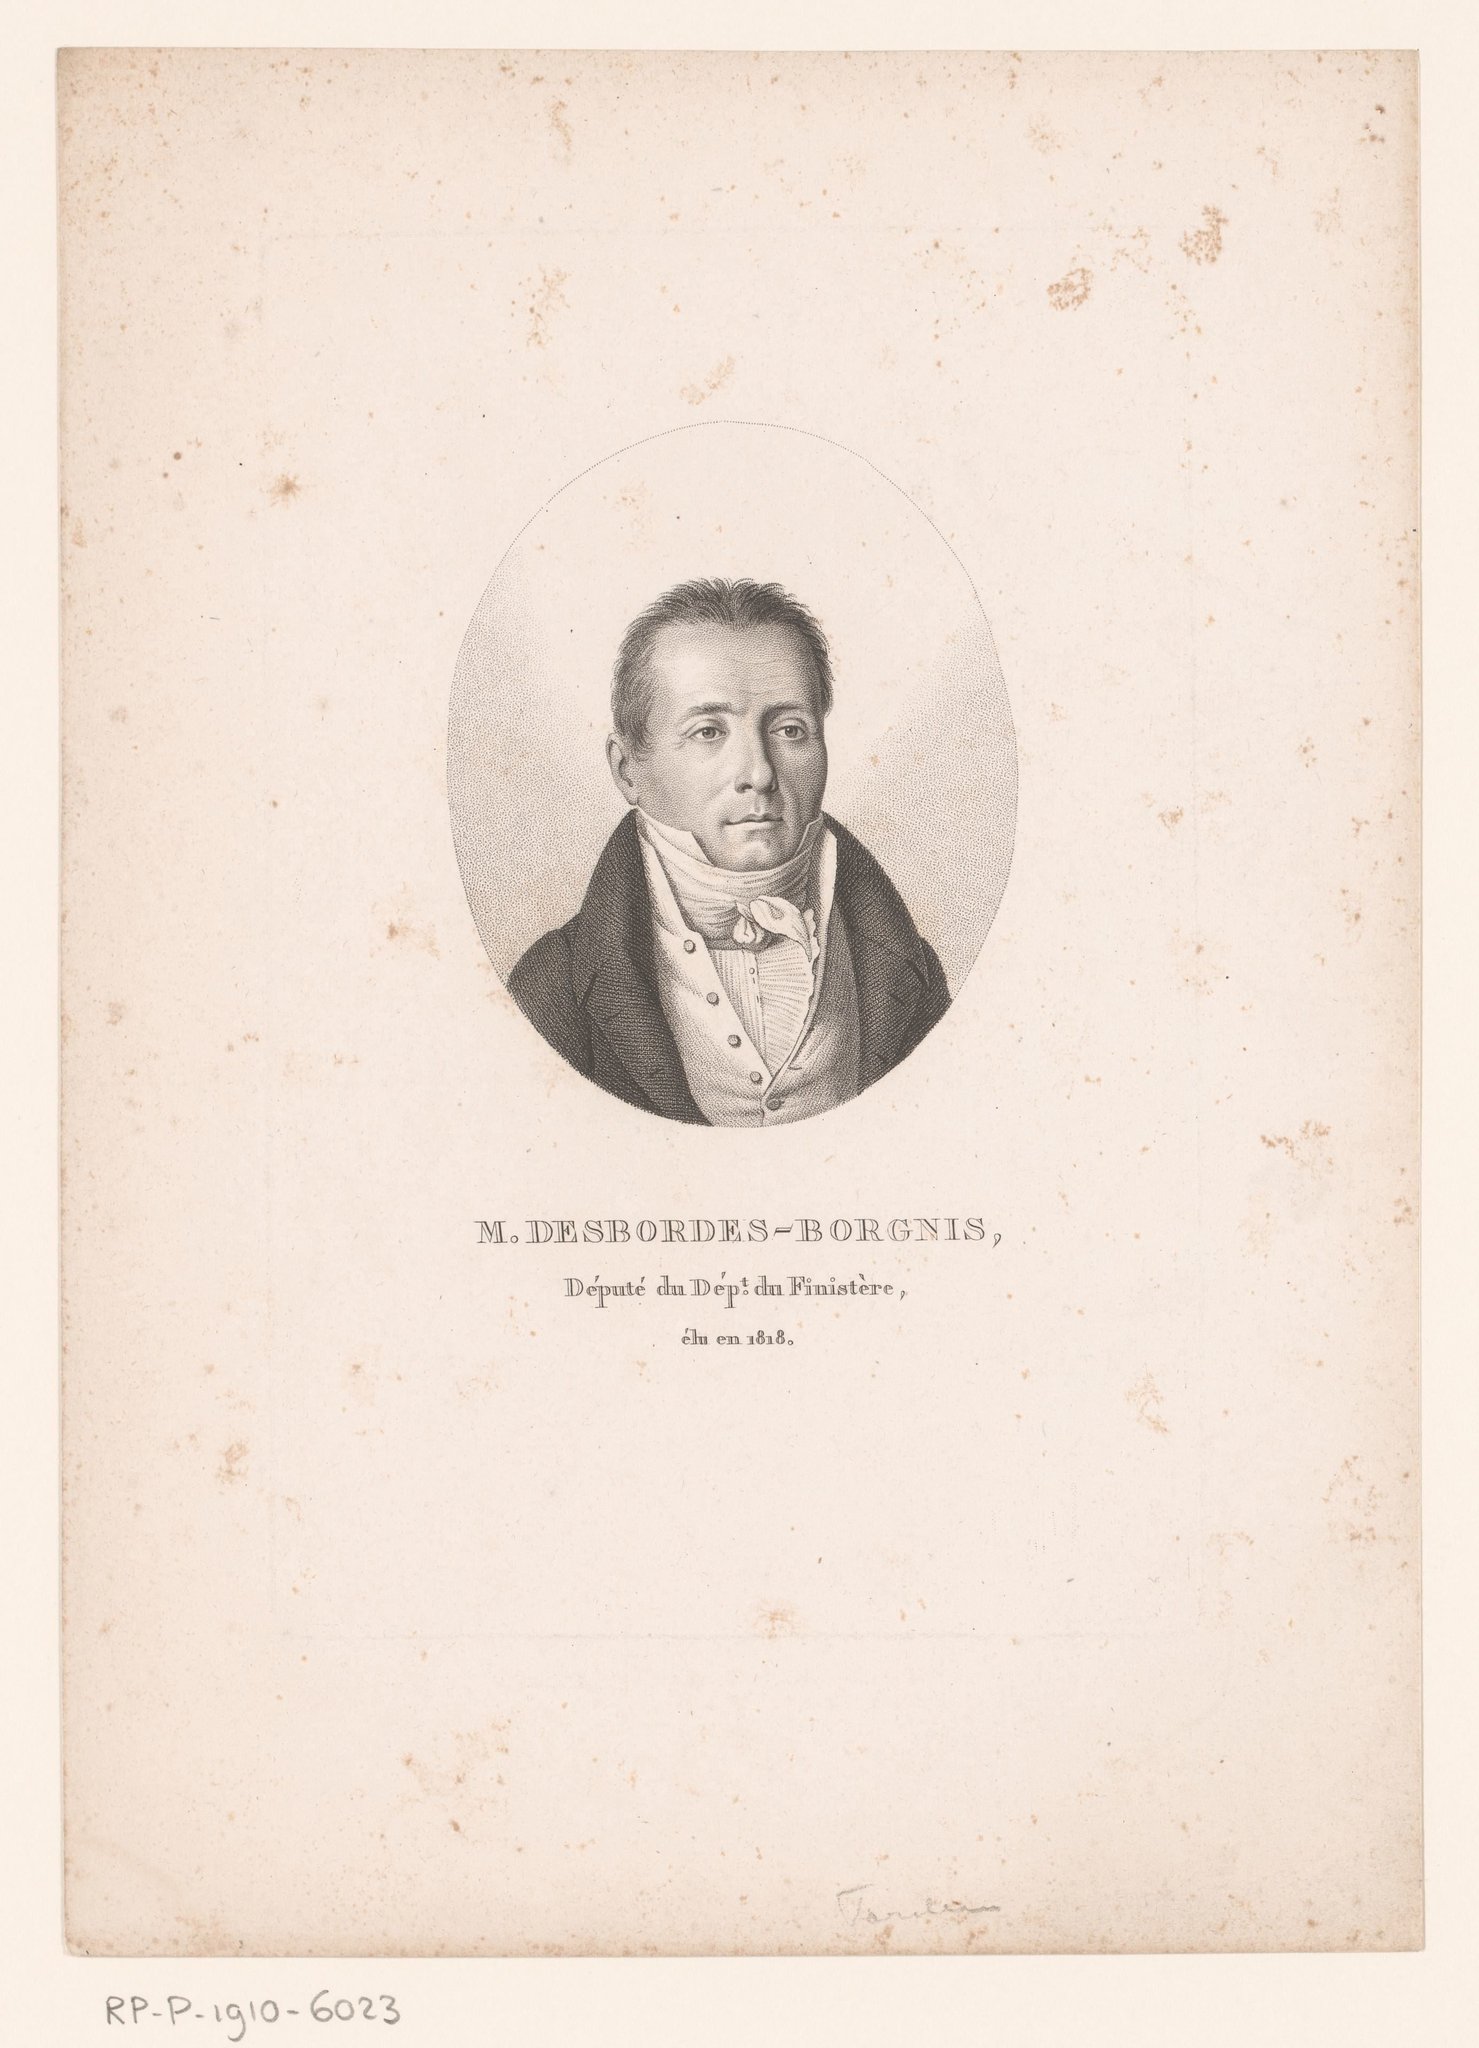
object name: print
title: Portret van François-Marie Borgnis-Desbordes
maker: ambroise tardieu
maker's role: print maker, printer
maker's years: 1788-1841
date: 1820-1821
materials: paper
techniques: engraving, roulette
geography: paris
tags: politician, historical persons, politician, e.g. party leader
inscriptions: collector's mark: Lugt 2228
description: Prent uit: Tardieu, Ambroise. Portraits des députés, écrivains et pairs constitutionnels, défenseurs invariables de la charte et de la loi des élections du 5 février 1817. Parijs: Tardieu, Ambroise, 1820-1821.